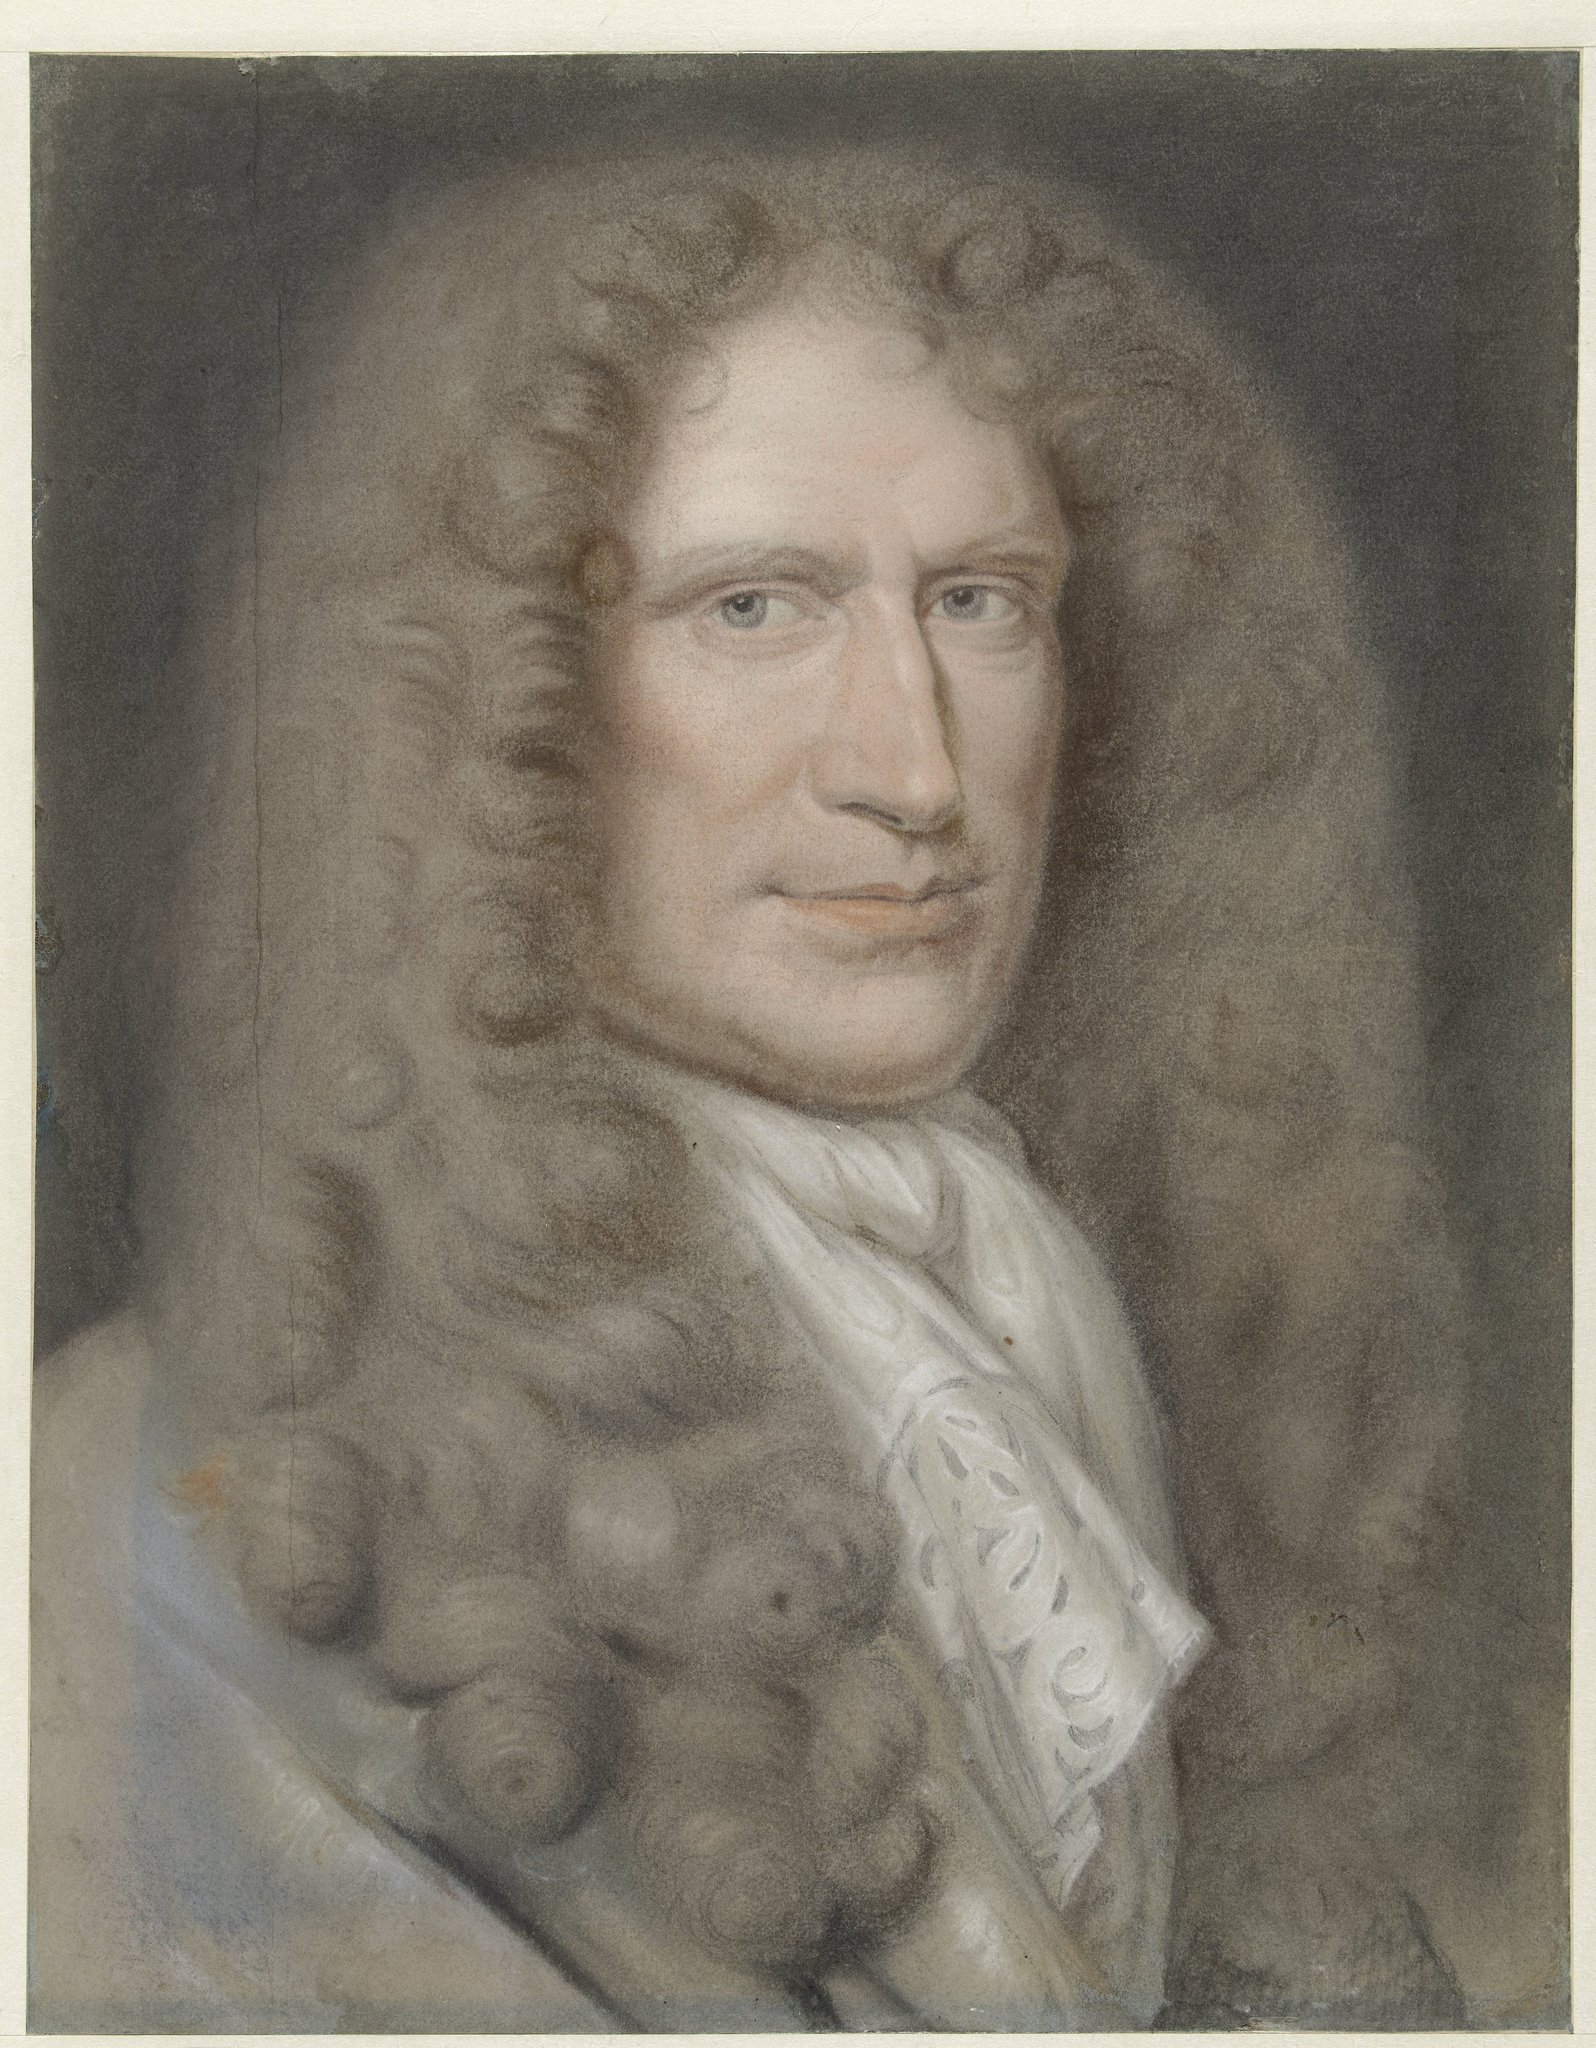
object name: drawing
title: Portret van een staatsman, naar rechts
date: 1633-1698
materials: paper, pastel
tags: anonymous historical person portrayed alone